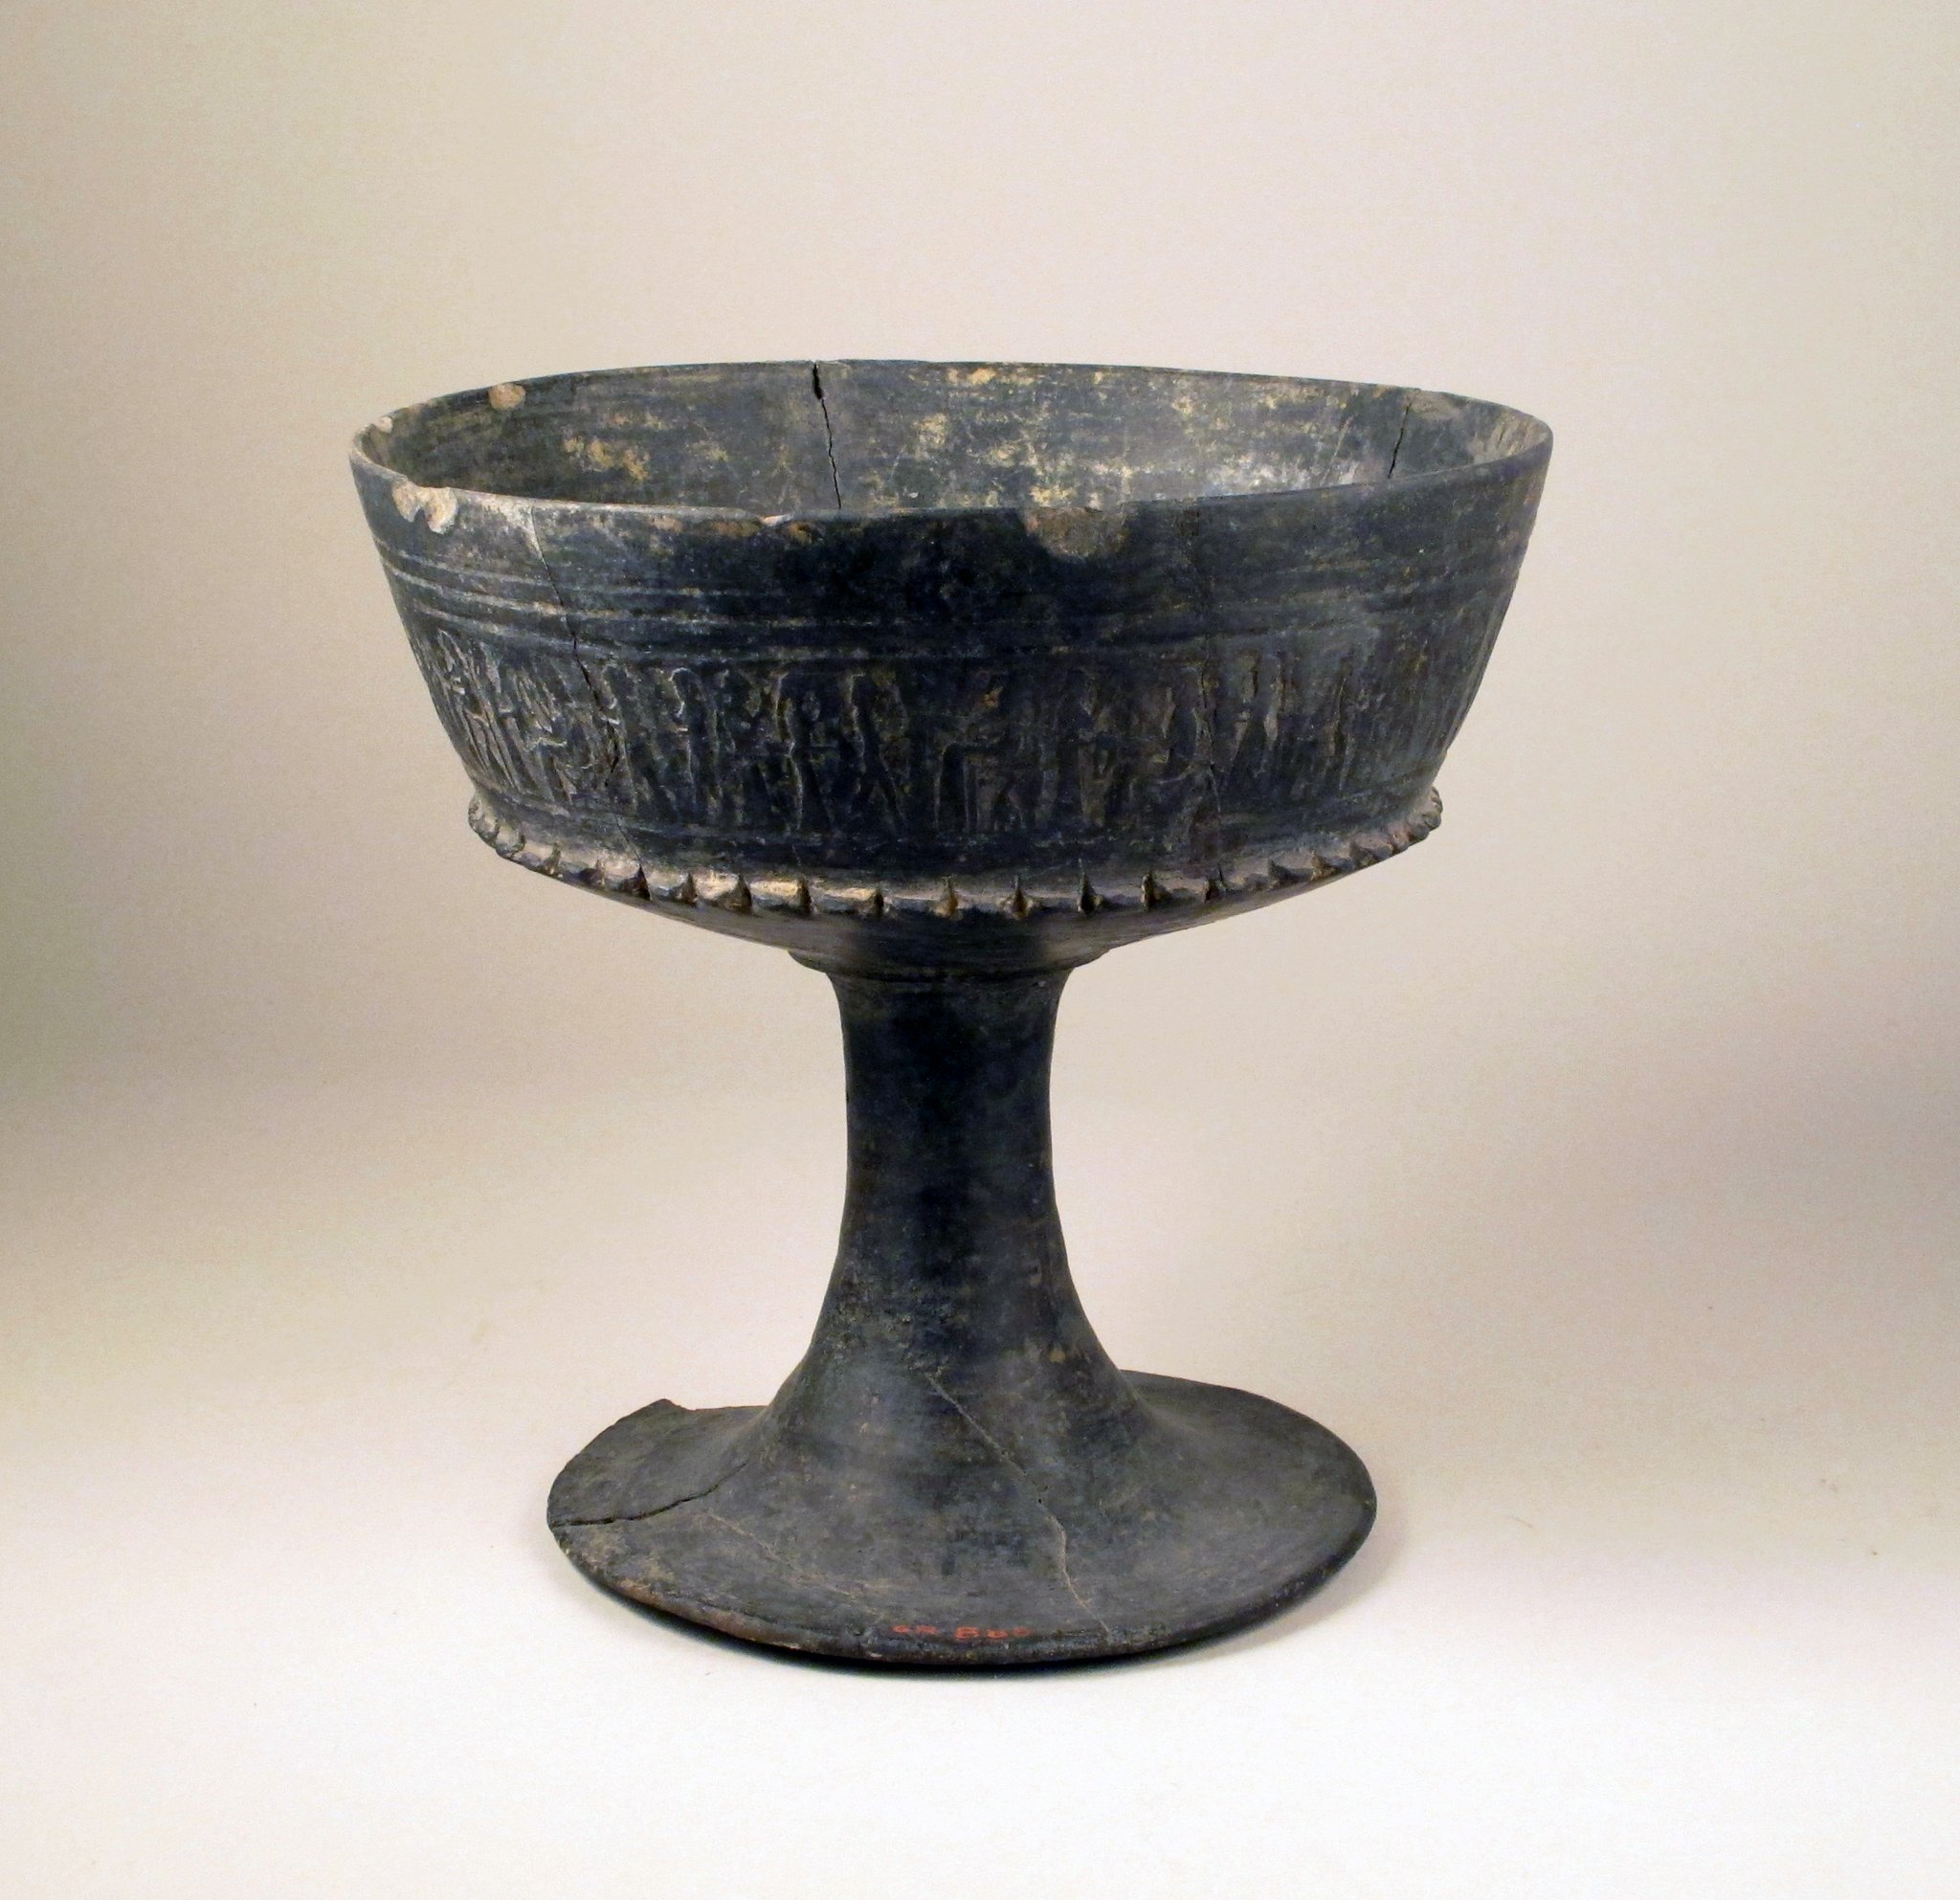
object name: cup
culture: etruscan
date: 600-551 BCE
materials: terracotta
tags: human figures